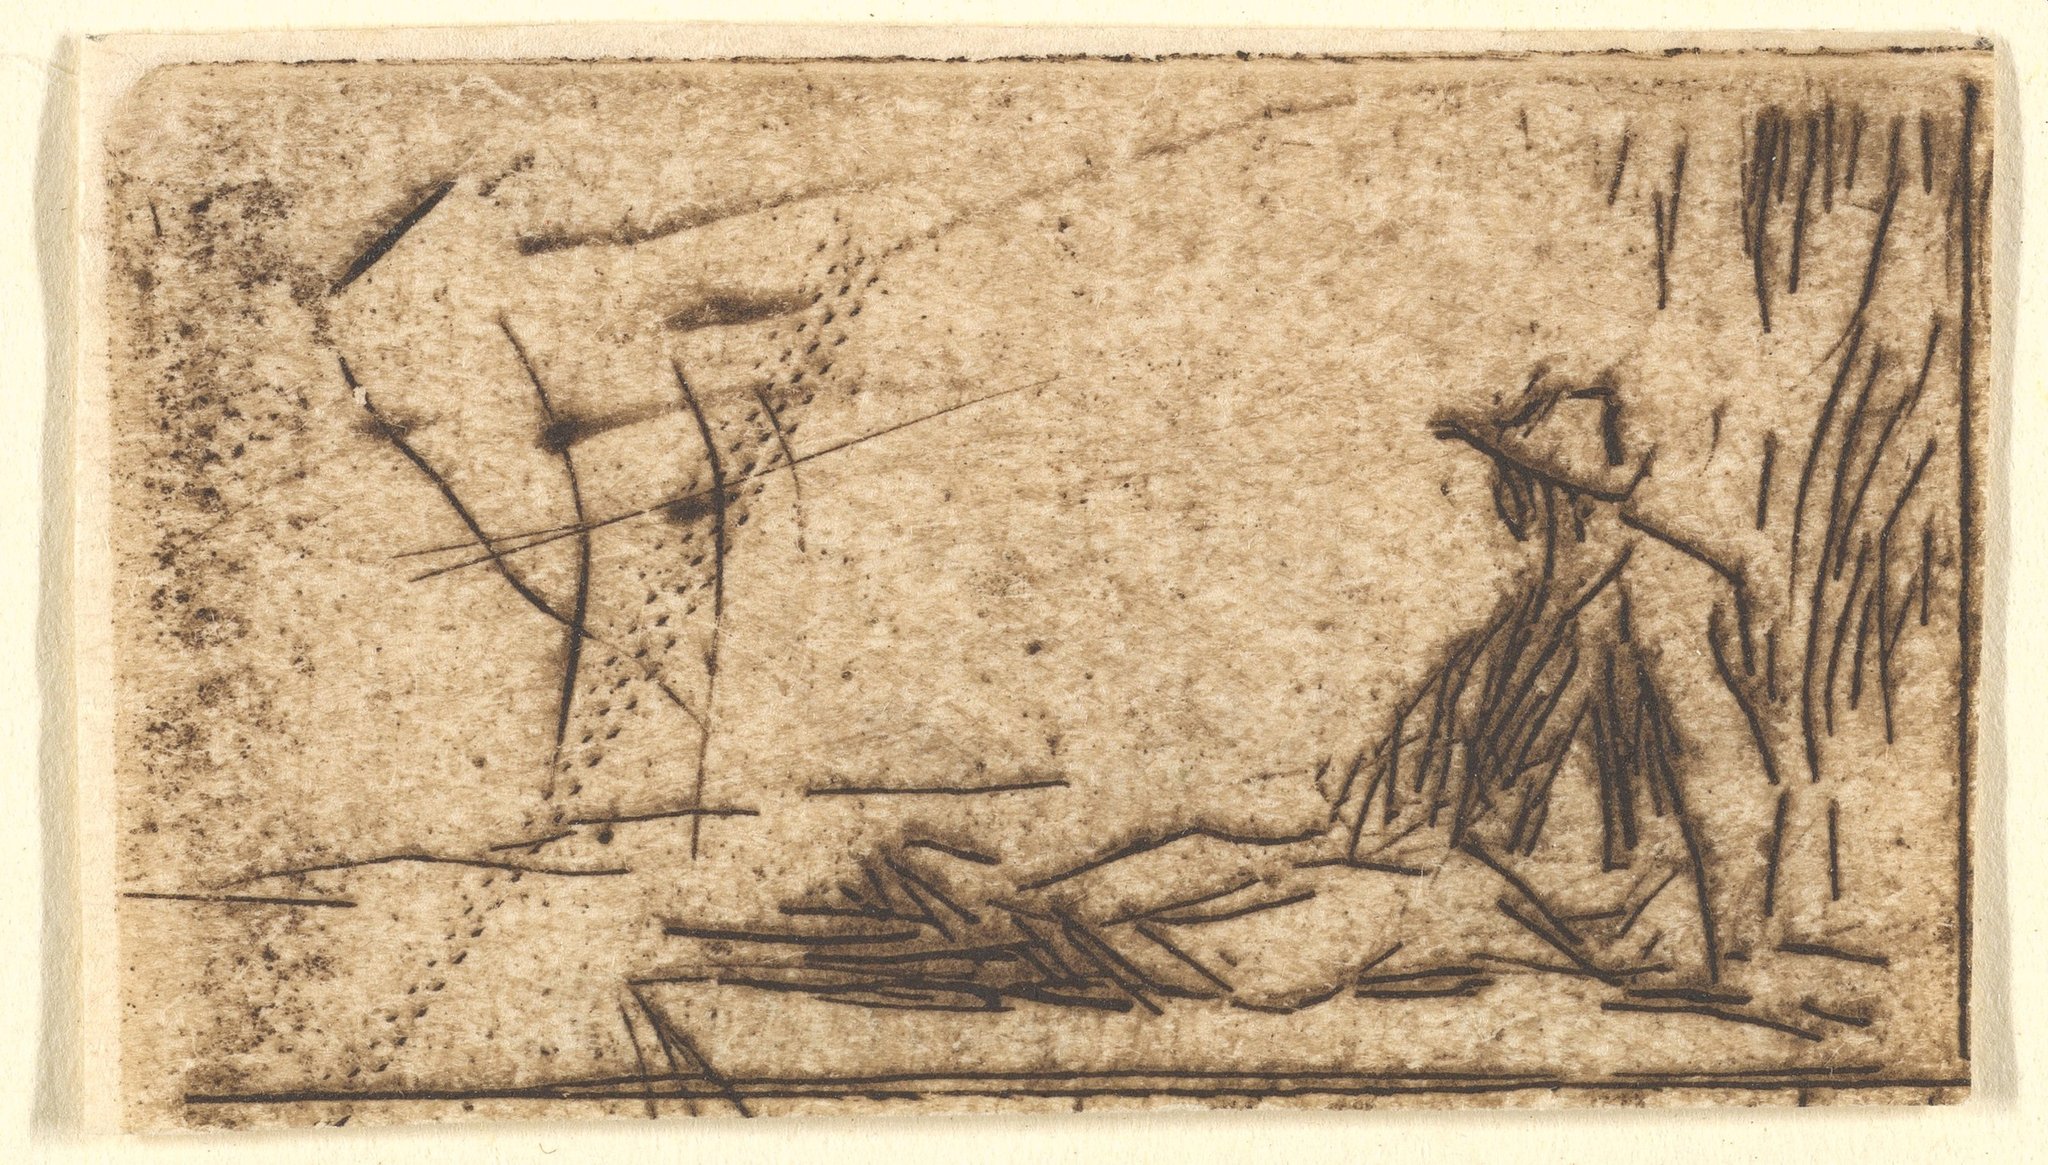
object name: print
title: Peasant Seated on the Ground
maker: jean-françois millet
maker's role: artist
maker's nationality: french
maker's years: 1814-1875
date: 1830-1875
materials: paper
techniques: etching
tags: men